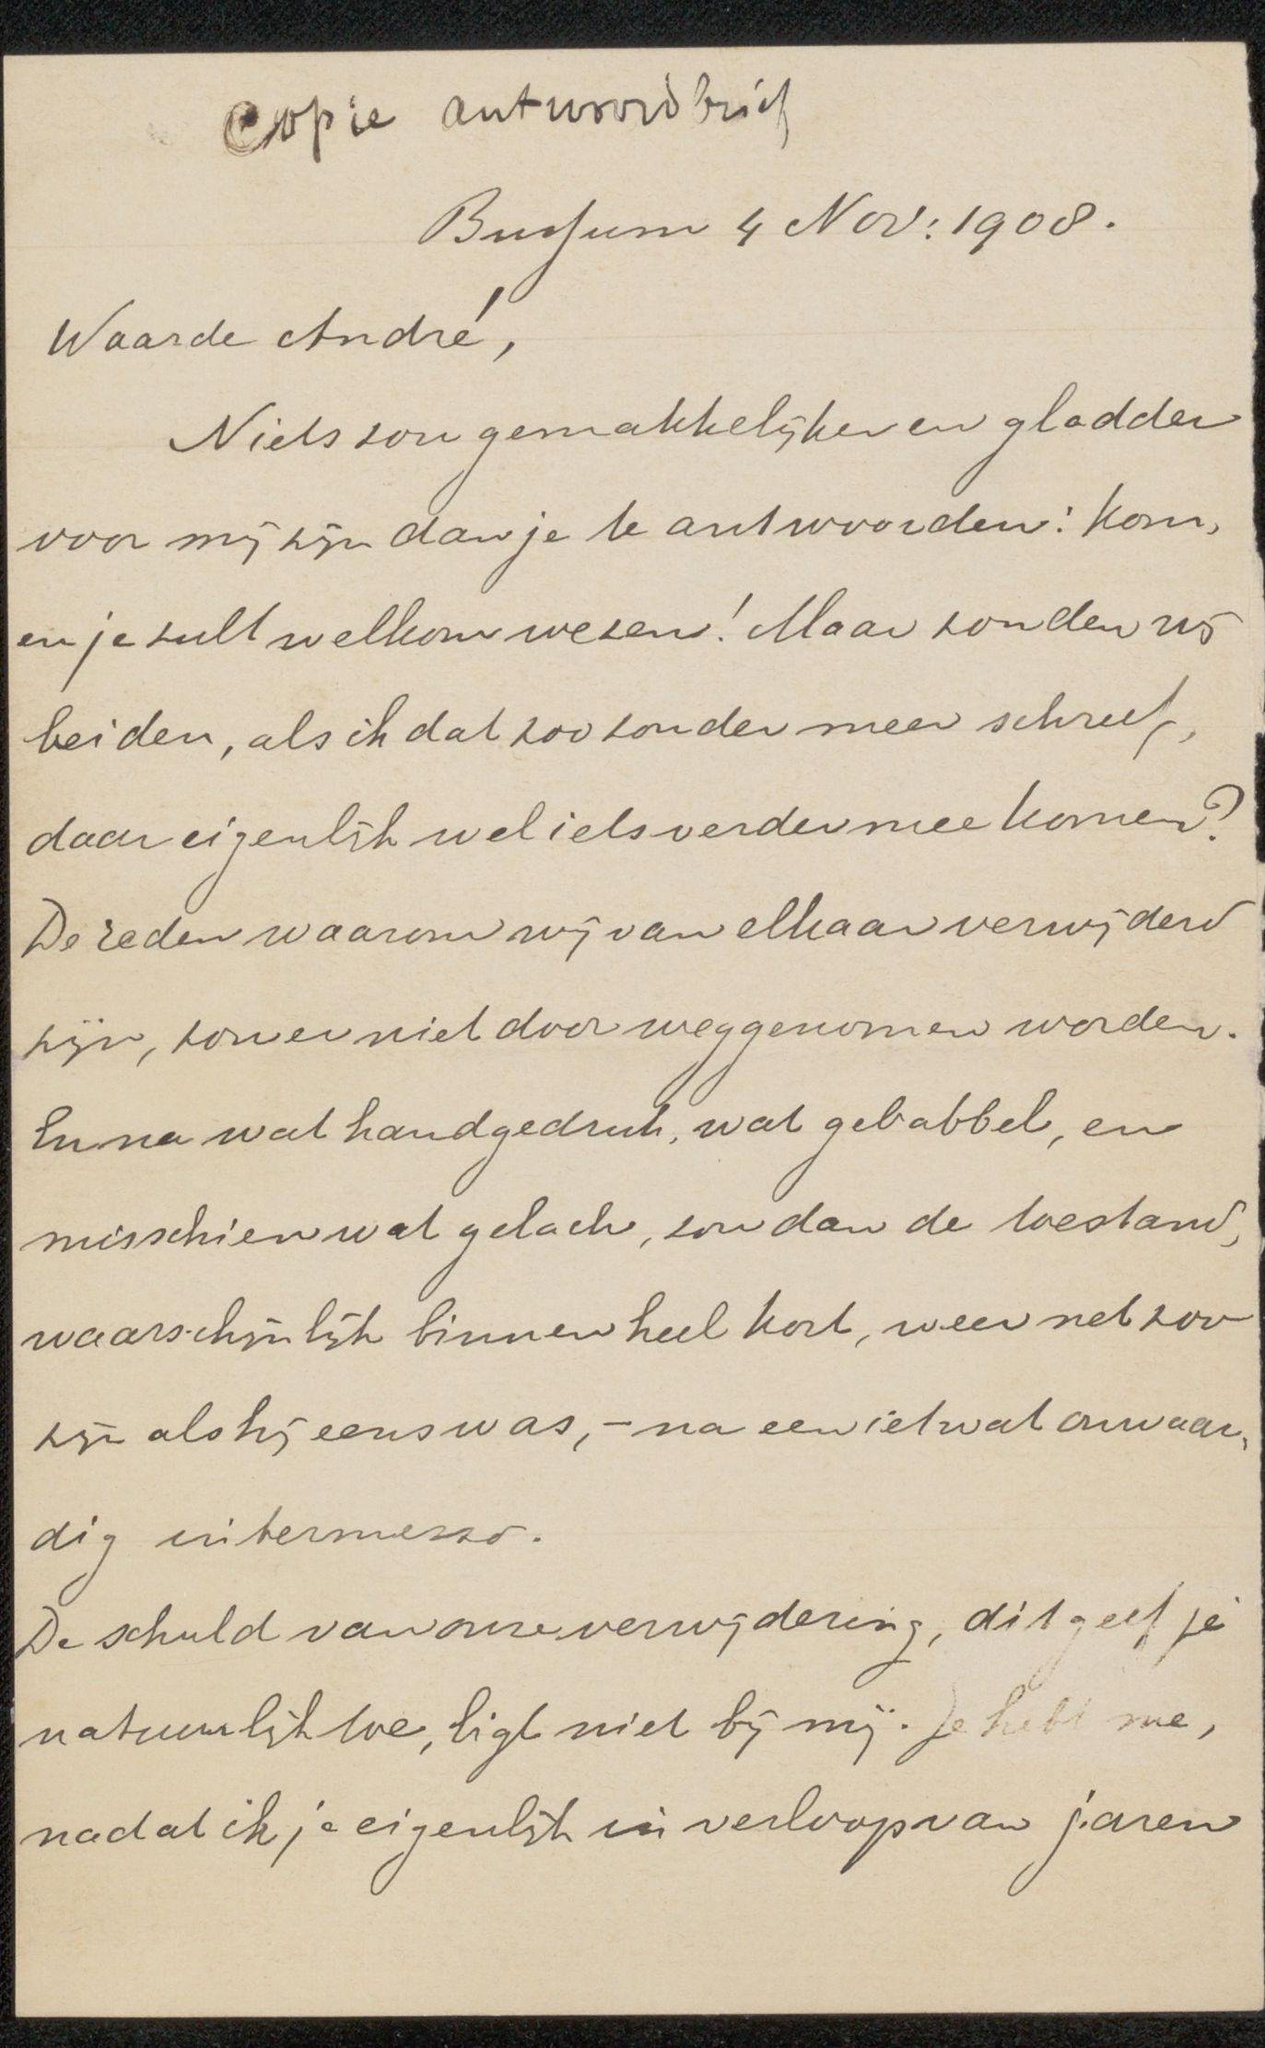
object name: letter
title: Brief aan André Jolles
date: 1908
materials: ink, paper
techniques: pen, writing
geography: bussum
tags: andré jolles, passions, emotions, affections, amsterdam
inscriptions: collector's mark: ‘RPK’, watermark